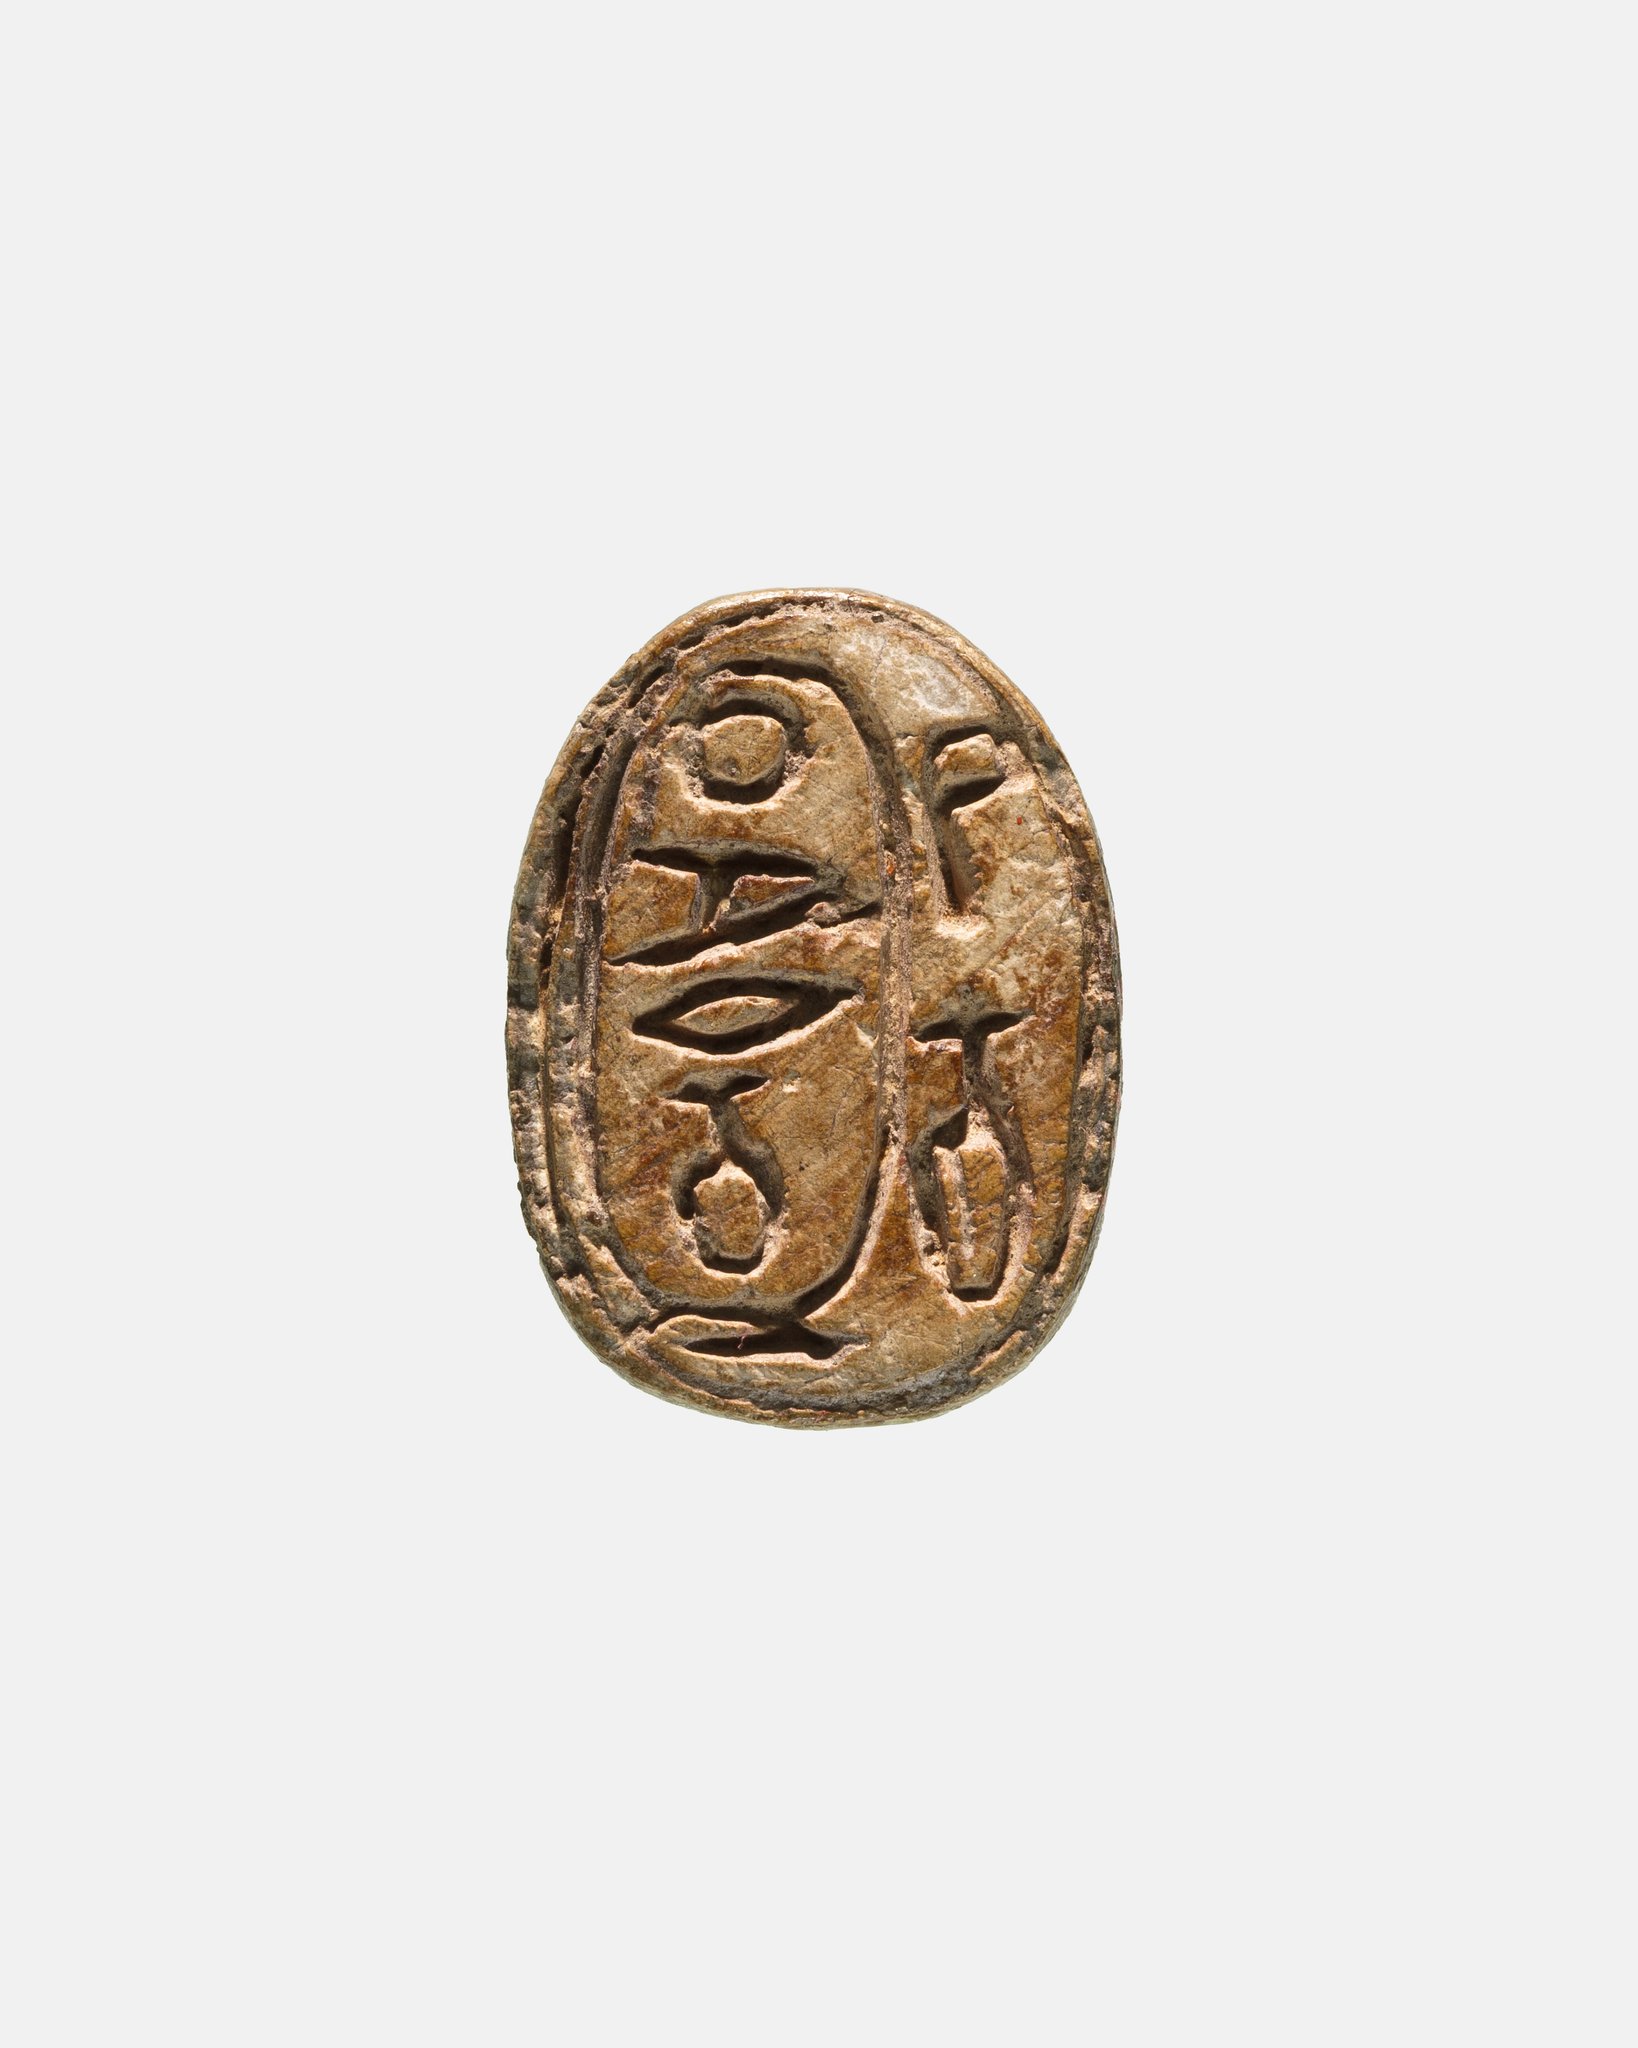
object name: scarab, merneferre aya, cartouche, hieroglyph, royal title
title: Scarab Inscribed for Pharaoh Aya (I)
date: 1700-1676 BCE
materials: stone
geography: egypt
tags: scarabs